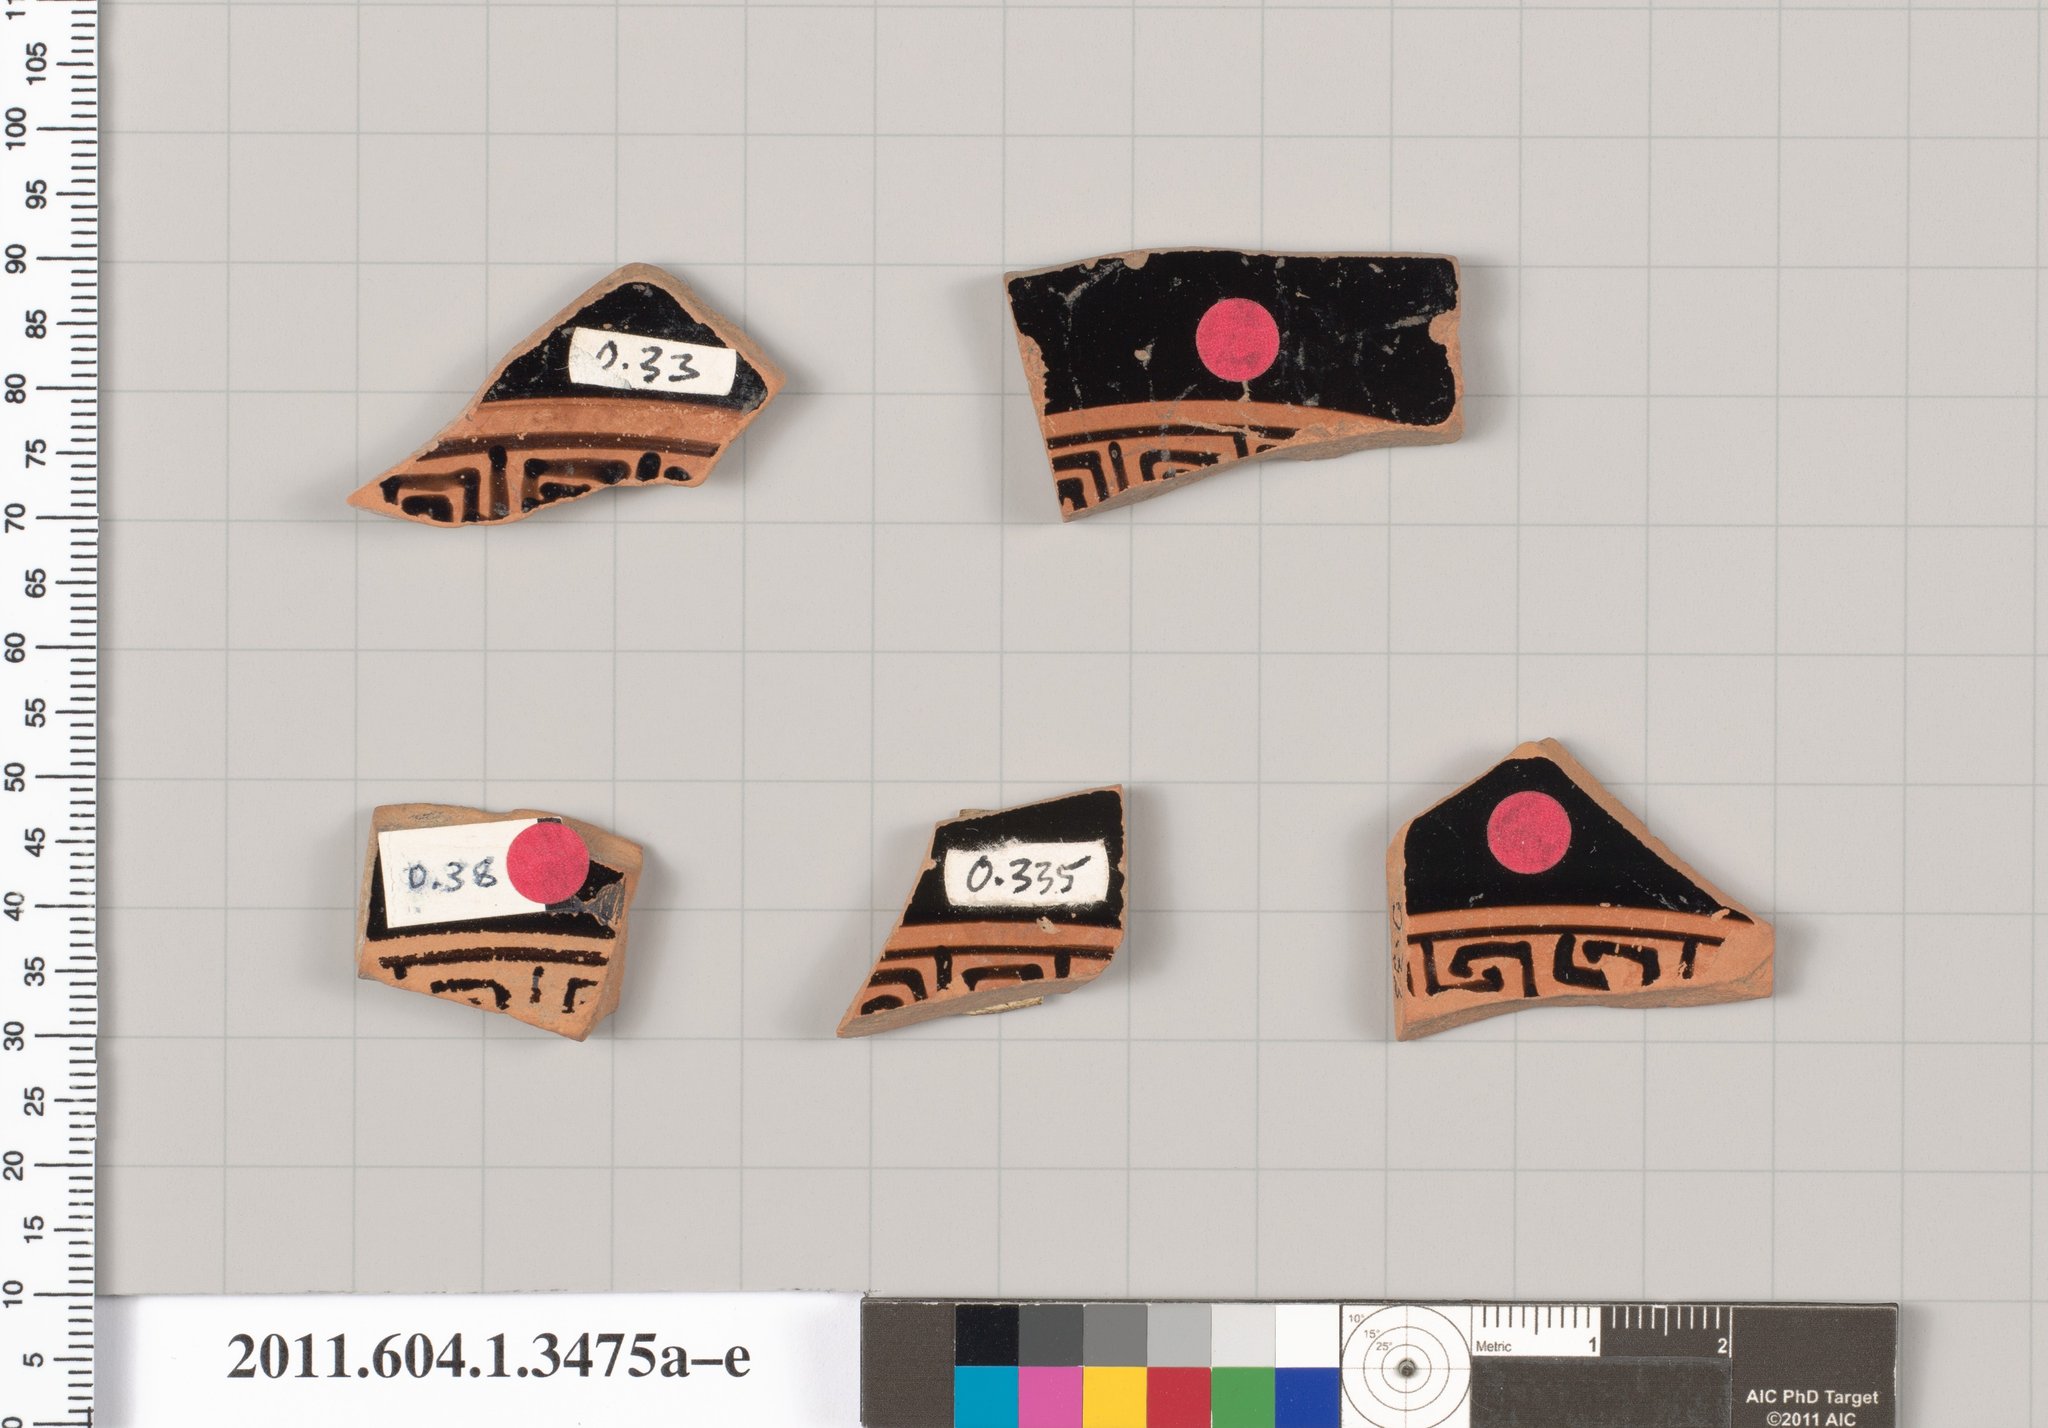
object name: kylix fragment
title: Terracotta fragments of kylikes (drinking cups)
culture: greek, attic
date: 500-475 BCE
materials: terracotta